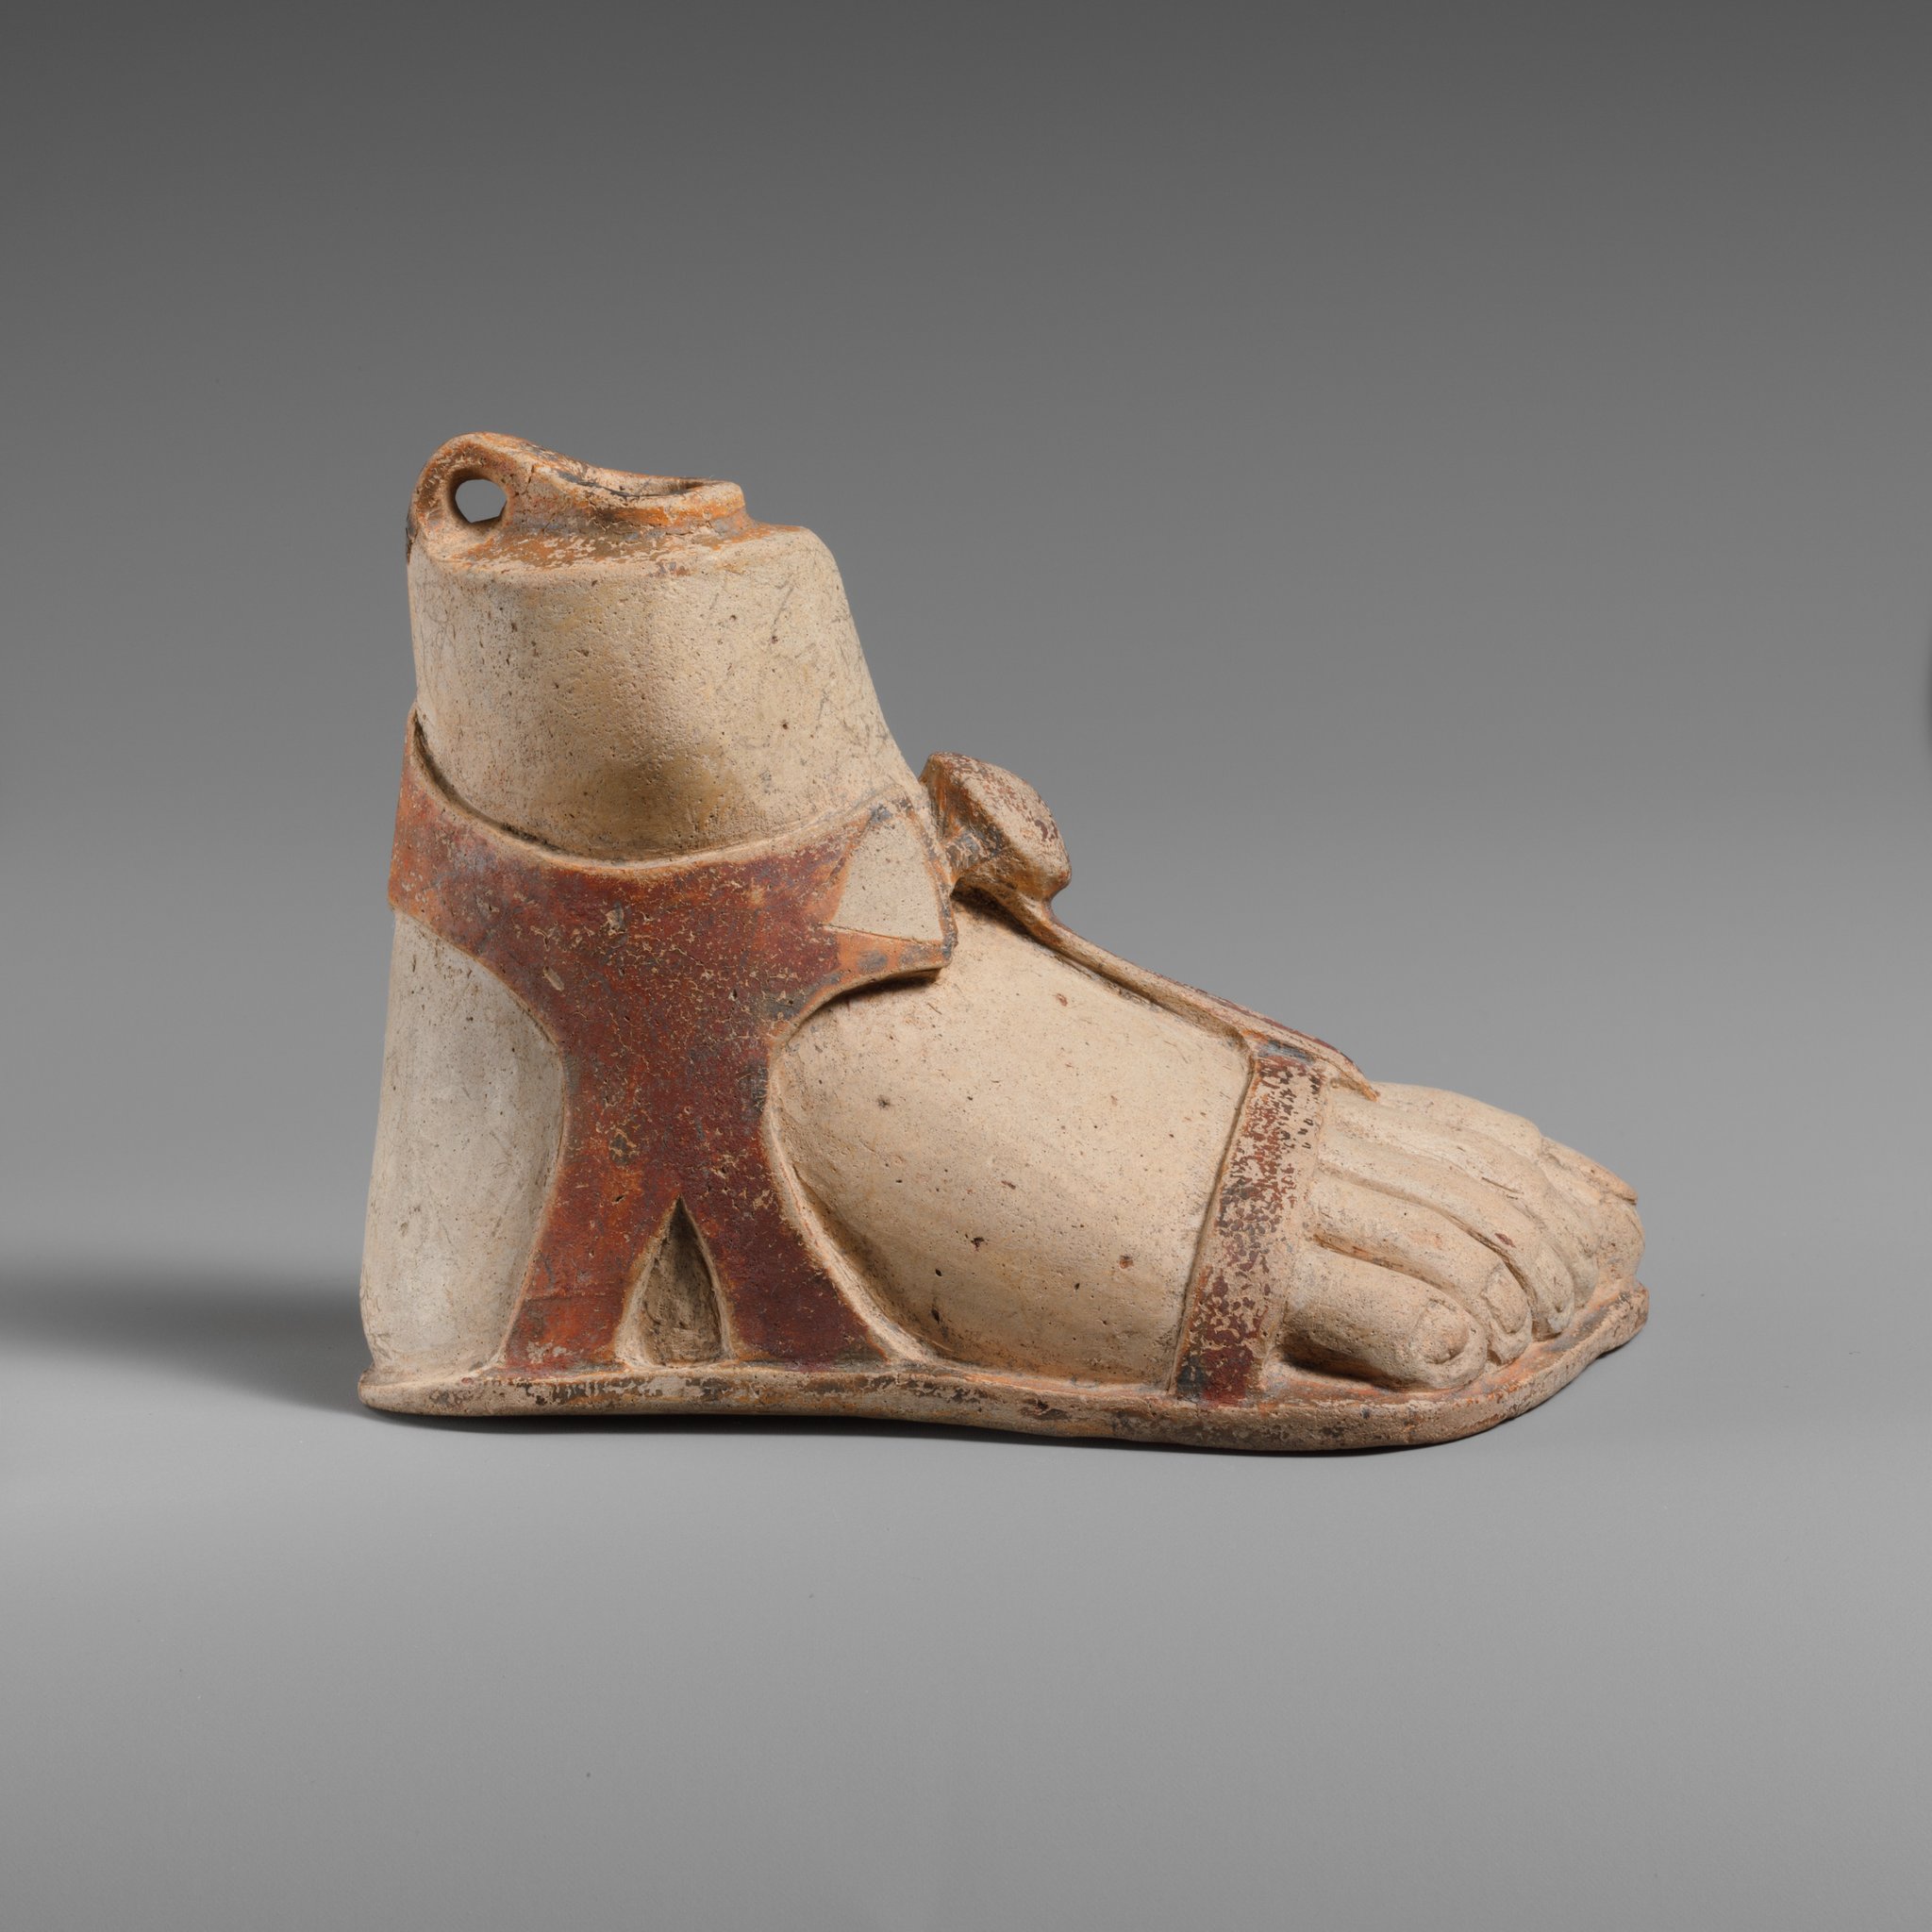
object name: vase in the form of a sandaled right foot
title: Terracotta aryballos (perfume vase) in the form of a sandaled right foot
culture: rhodian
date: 567-535 BCE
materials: terracotta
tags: feet